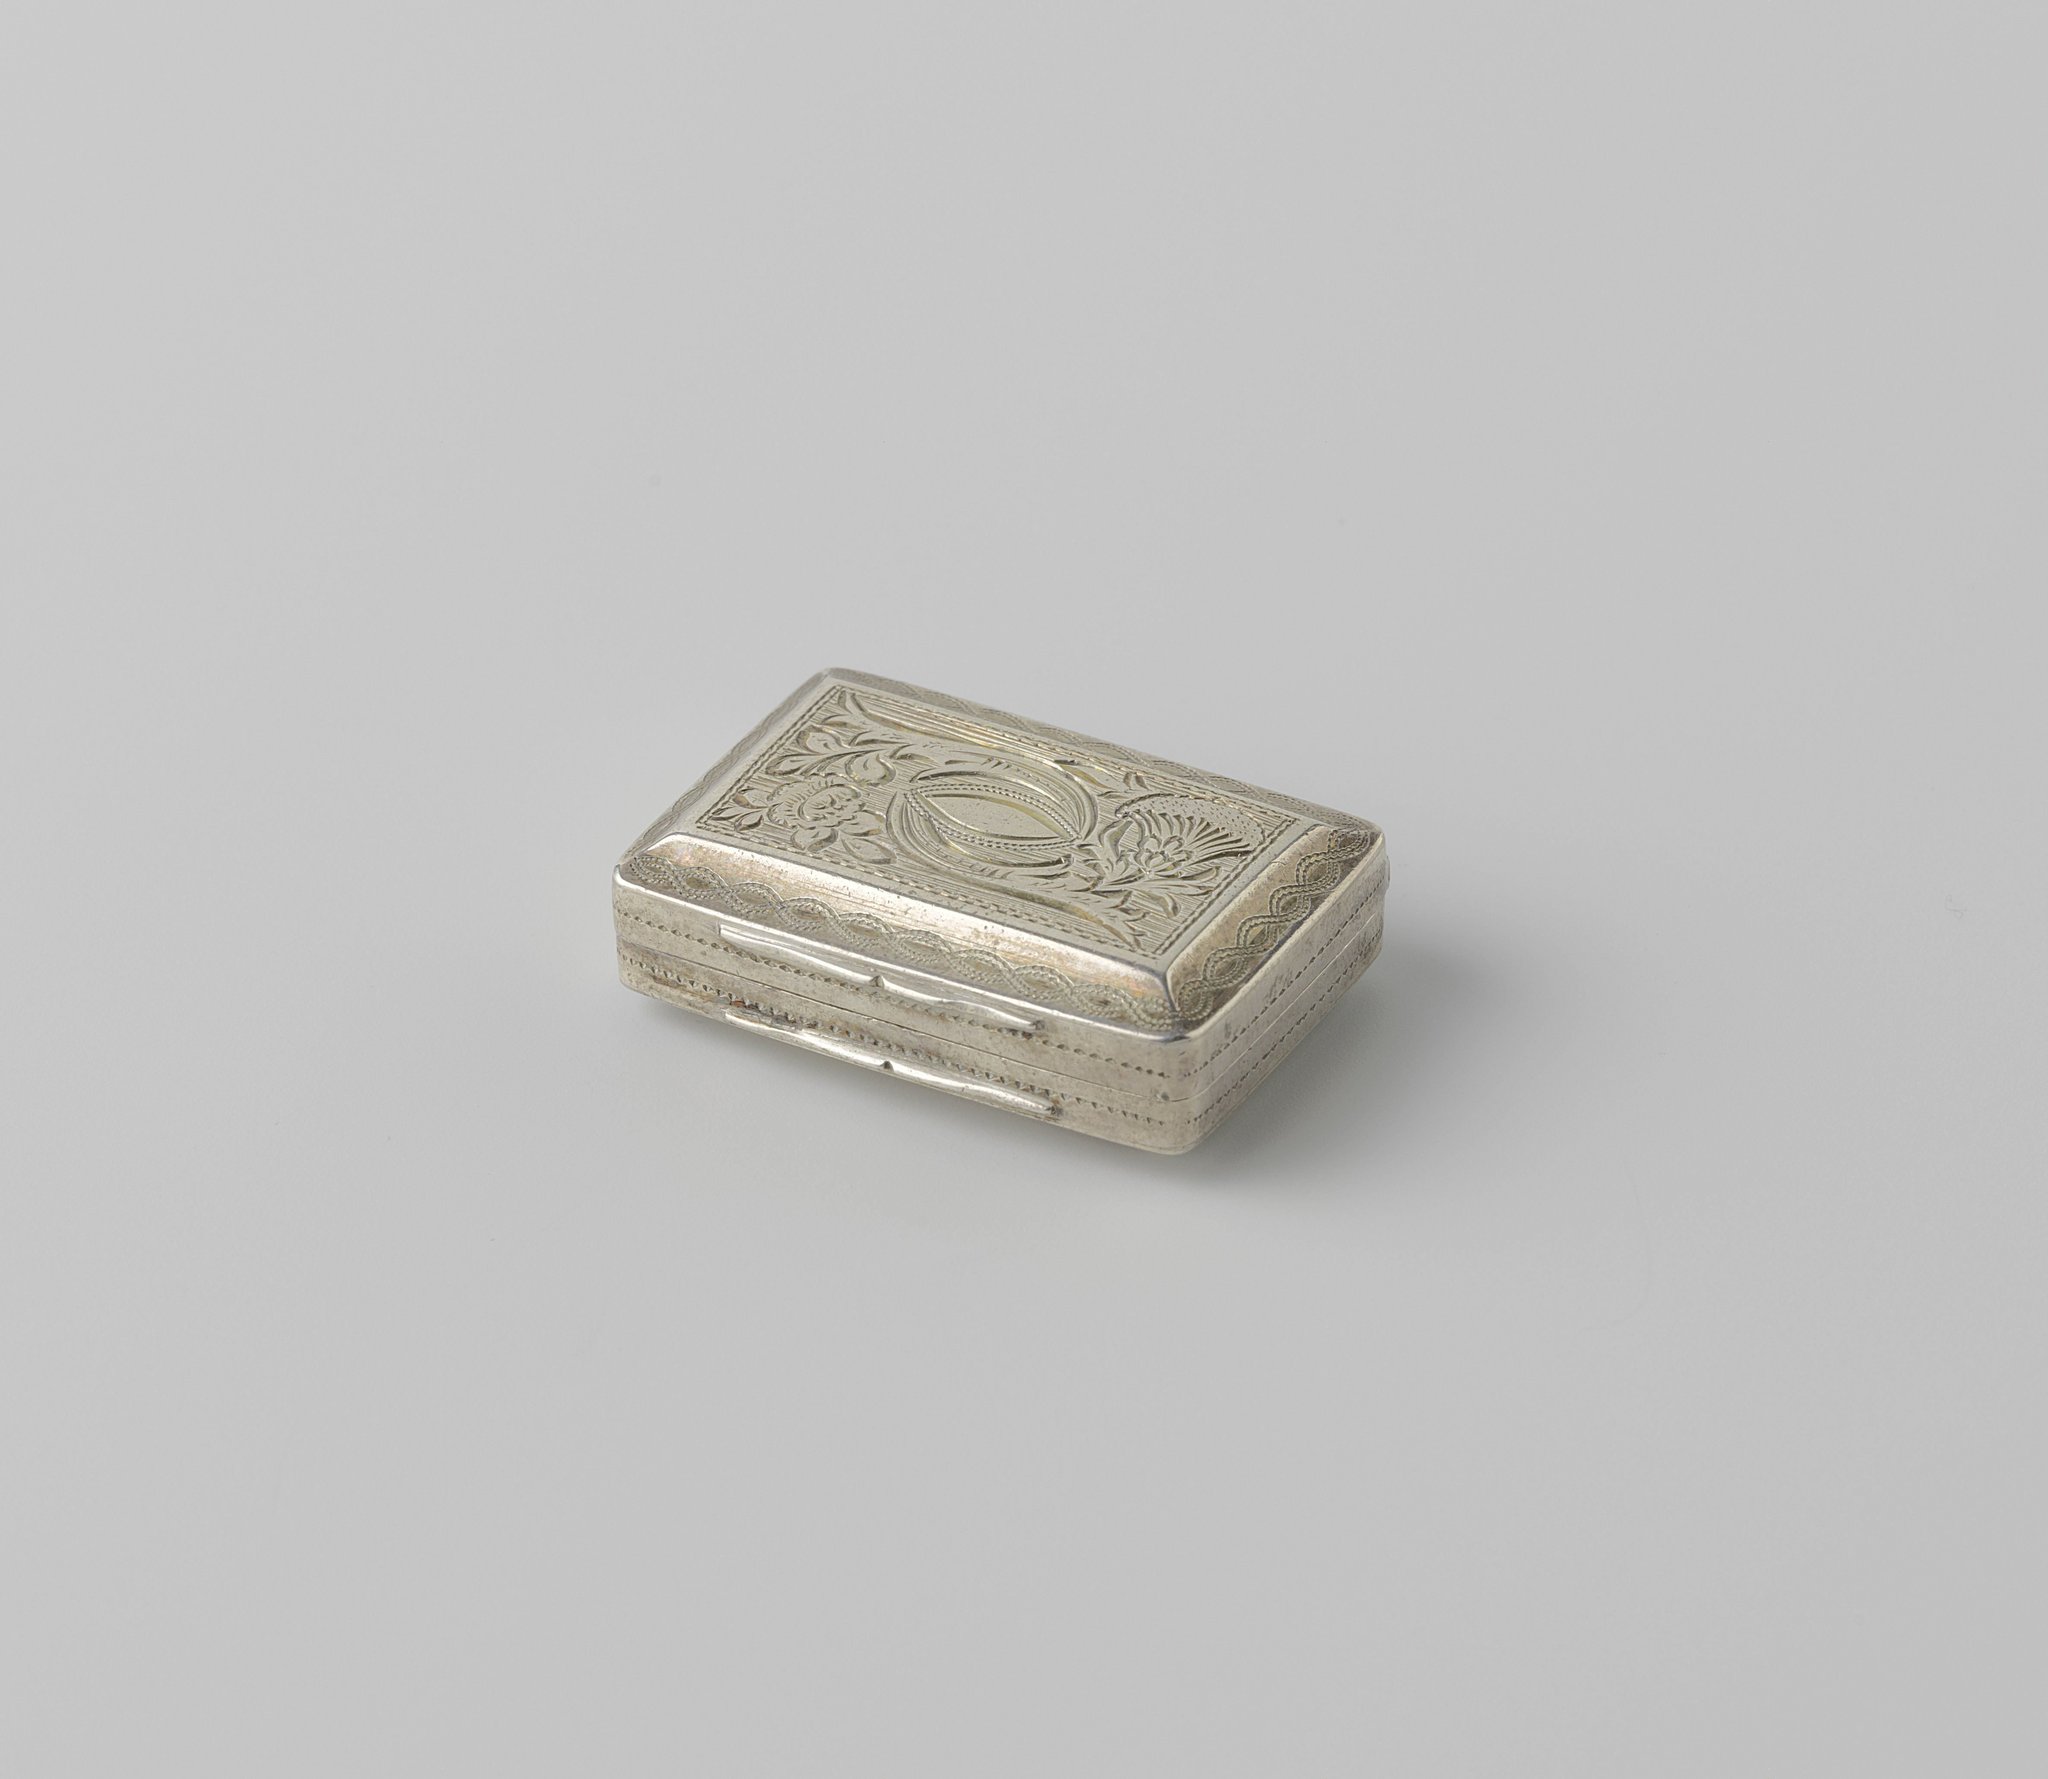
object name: eating drinking utensil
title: Vinaigrettehouder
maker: john bettridge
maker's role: silversmith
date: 1823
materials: silver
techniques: gilding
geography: birmingham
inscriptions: mark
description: Vinaigrettehouder van gedeeltelijk verguld zilver, rechthoekig met afgeronde hoeken. Het bestaat uit 2 delen van gelijke grootte, die aan een van de lange zijden scharnierend aan elkaar bevestigd zijn. De vinaigrette bevat een compartiment met een scharnierend deksel waarin zich een sponsje bevindt.